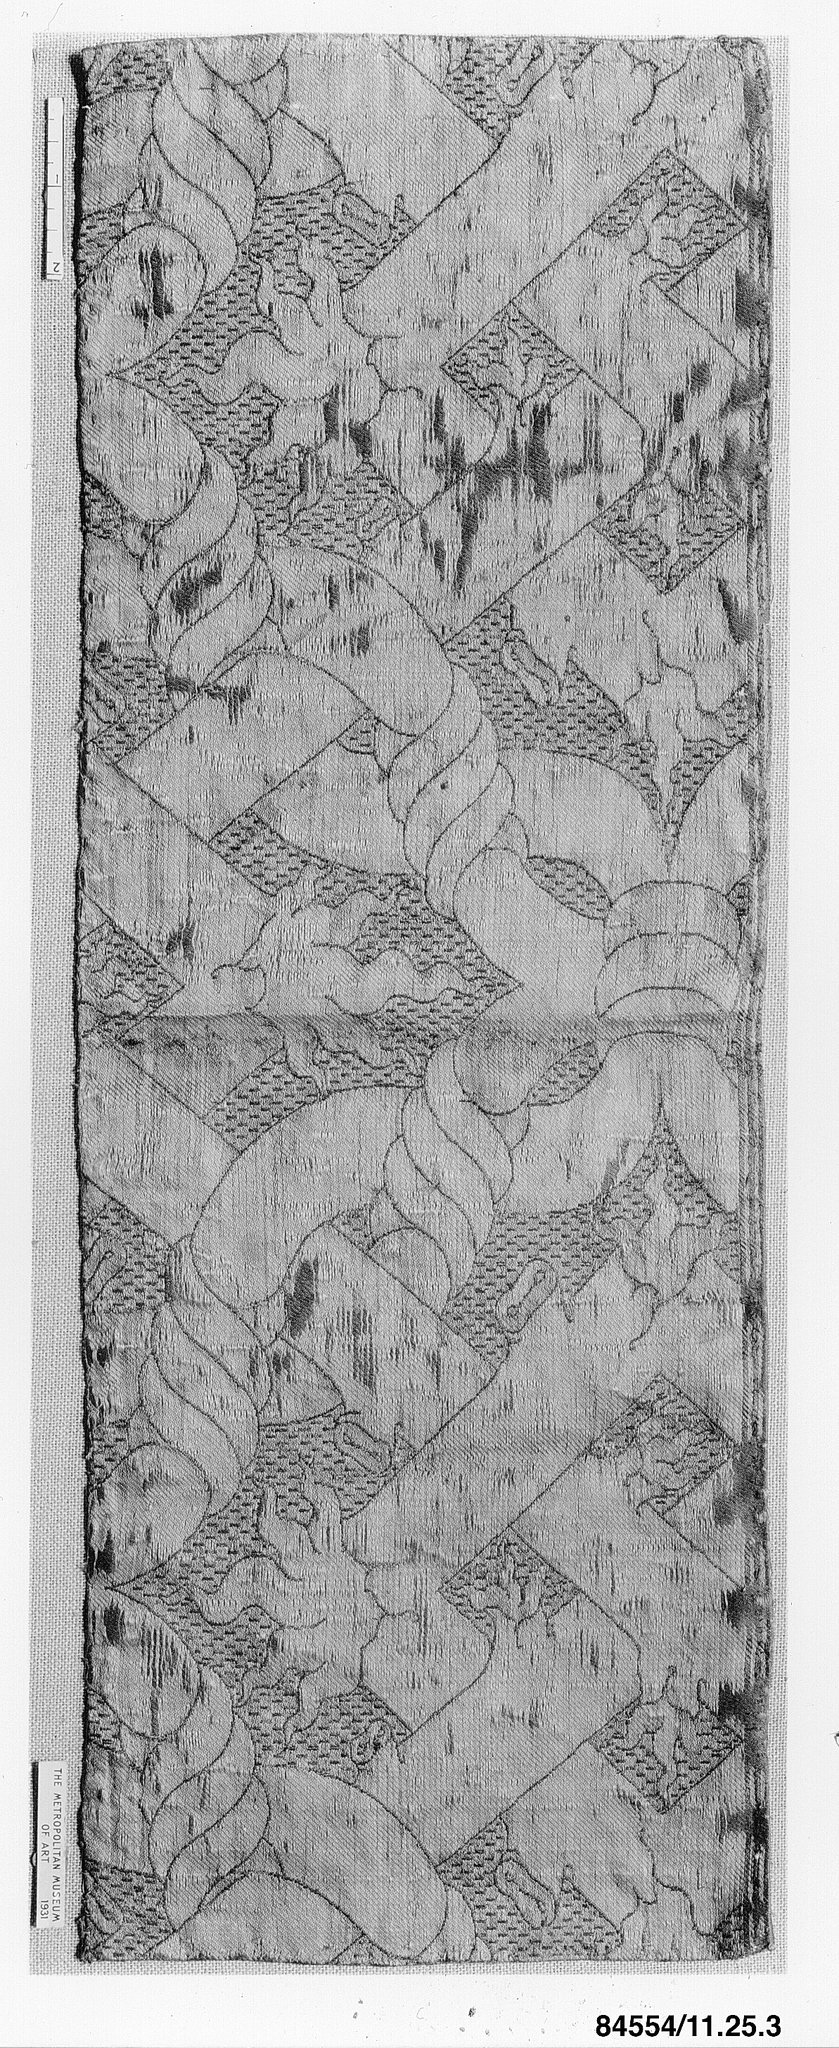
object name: fragment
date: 1500-1550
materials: metal thread, silk